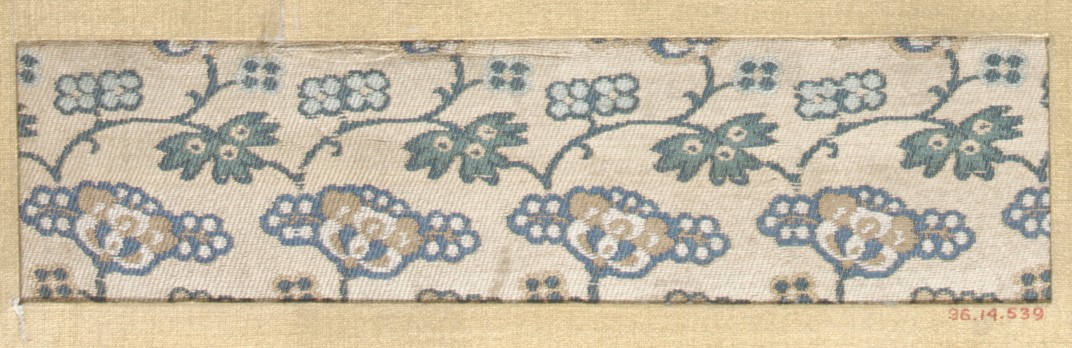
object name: piece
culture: japanese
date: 1701-1900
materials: silk